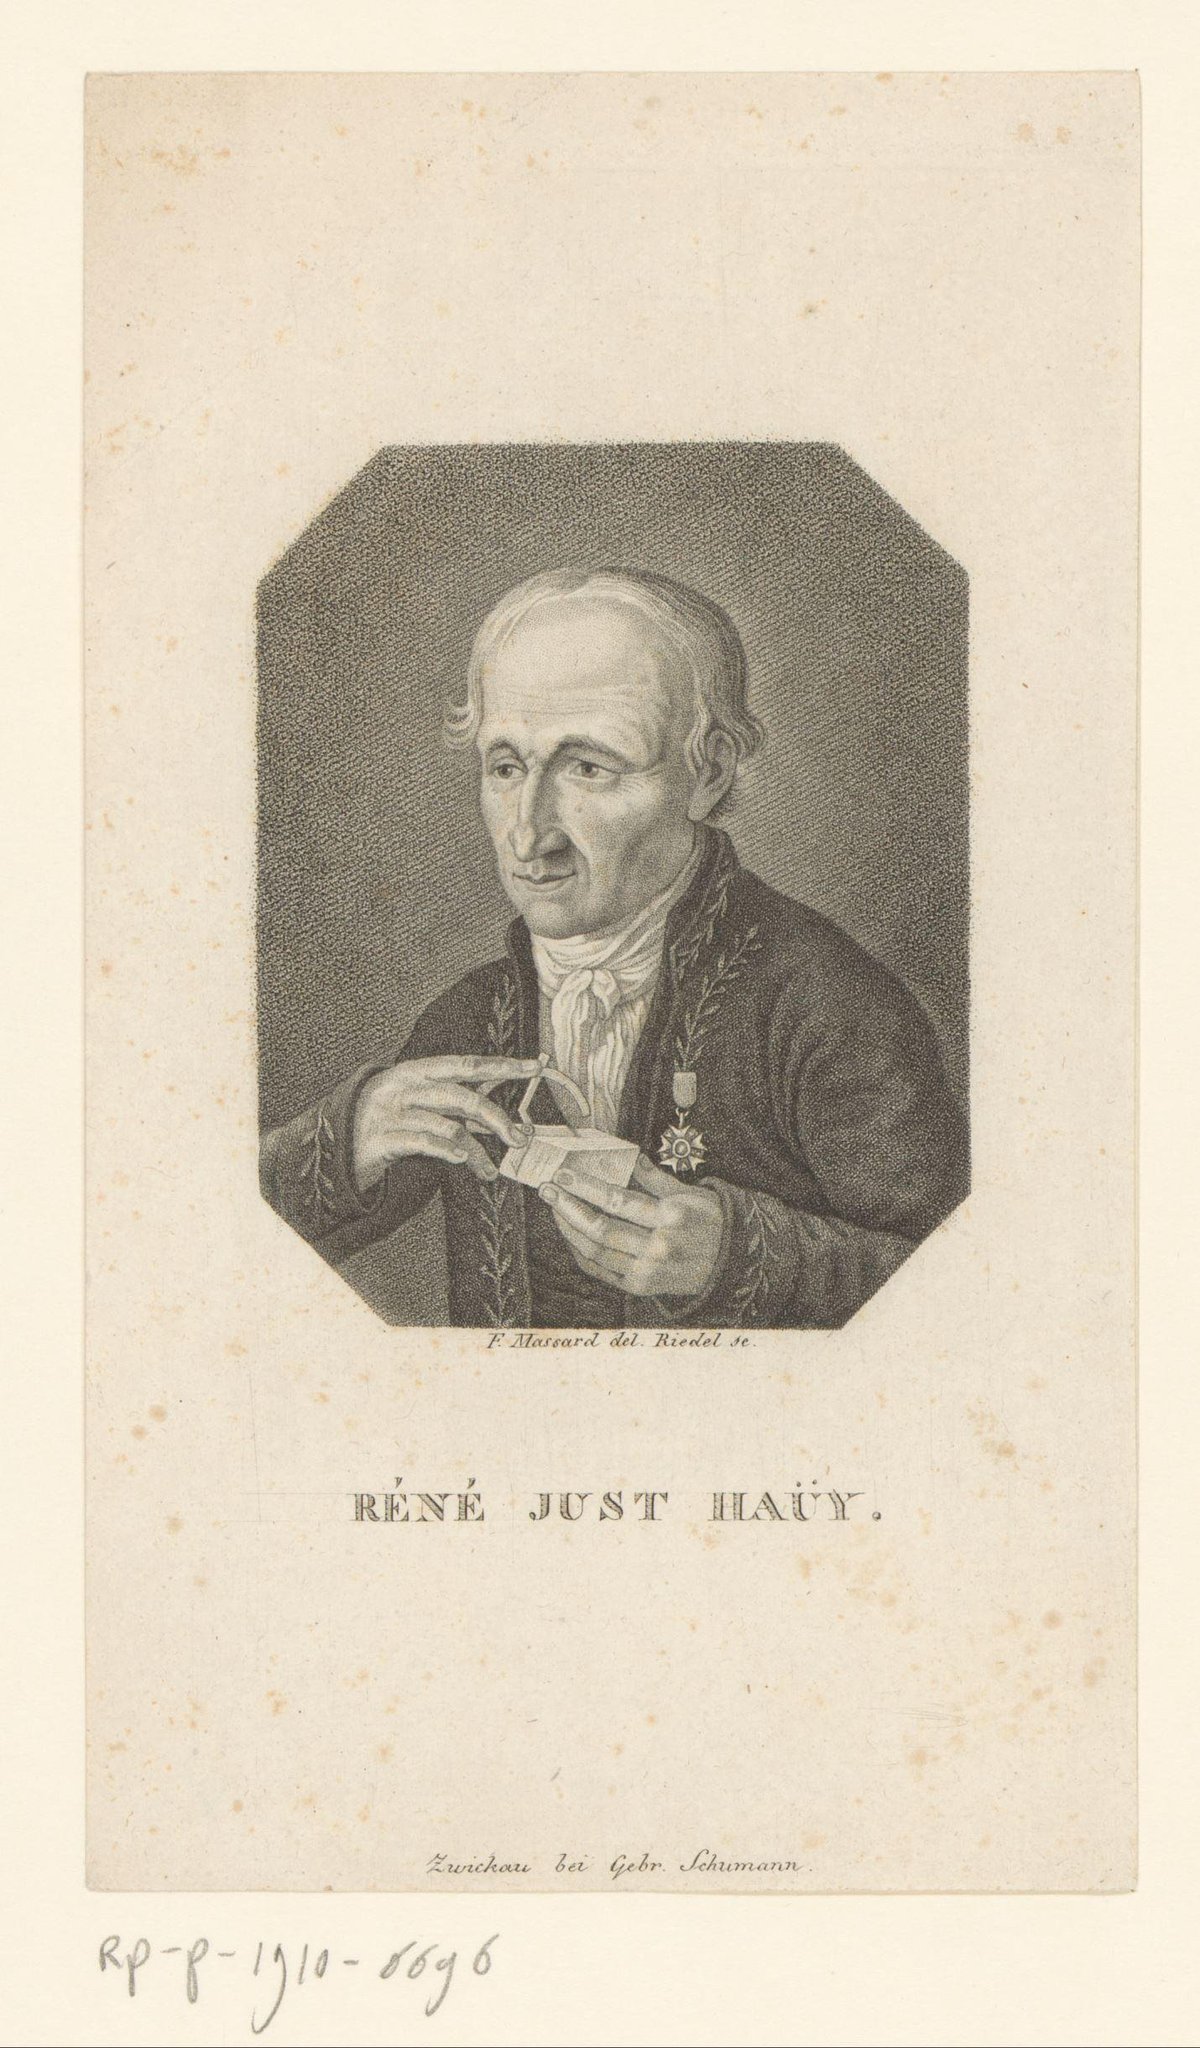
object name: print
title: Portret van René Just Haüy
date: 1779-1850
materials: paper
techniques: engraving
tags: france, paris, historical persons, measuring-instruments, medals and other marks of military honour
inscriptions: collector's mark: Lugt 2228